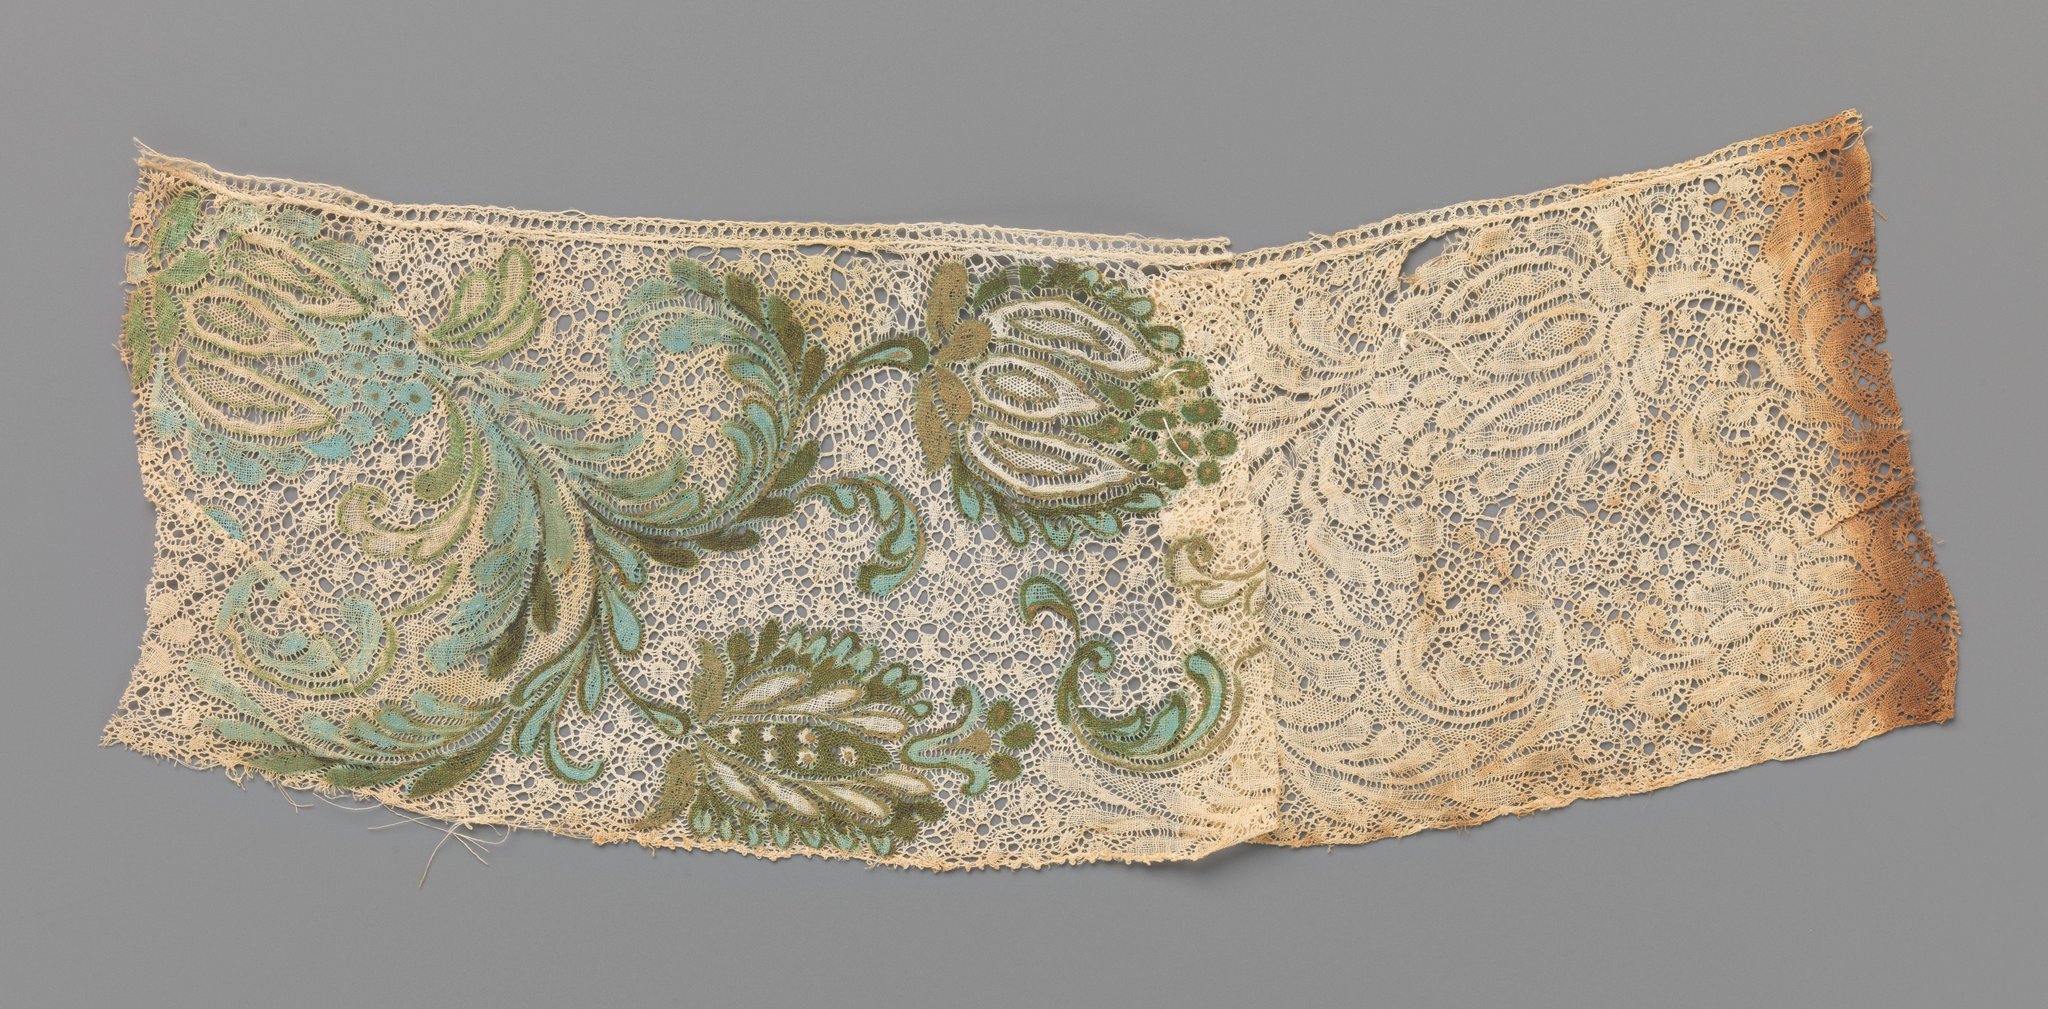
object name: strip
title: Strook kloskant met lichtblauw en groen beschilderde bloemen en bladeren met enkele goudkleurige accenten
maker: Anonymous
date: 1740-1760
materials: linen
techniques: lace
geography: southern netherlands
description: Strook naturelkleurige kloskant, Binche-kant, waarbij het patroon lichtblauw en groen is beschilderd, met enkele goudkleurige accenten. Het schilderwerk is niet helemaal afgemaakt. De strook is met enkele steken vastgenaaid aan een strook met hetzelfde, maar onbeschilderde patroon. Het patroon bestaat uit gevederde bladeren, gebogen en omkrullend, met een pluimvormige bloem en een bloem in de vorm van een dennenappel. De motieven zijn met elkaar verbonden door een siergrond, een sneeuwvlokkengrond. Het volwerk is grotendeels gemaakt in linnenslag met opengewerkte randjes. Tussen sommige bladeren en in de bloemen is een netslagvulling toegepast. De onderzijde van de strook is recht afgewerkt. De bovenzijde is afgewerkt met een apart geklost bandje.